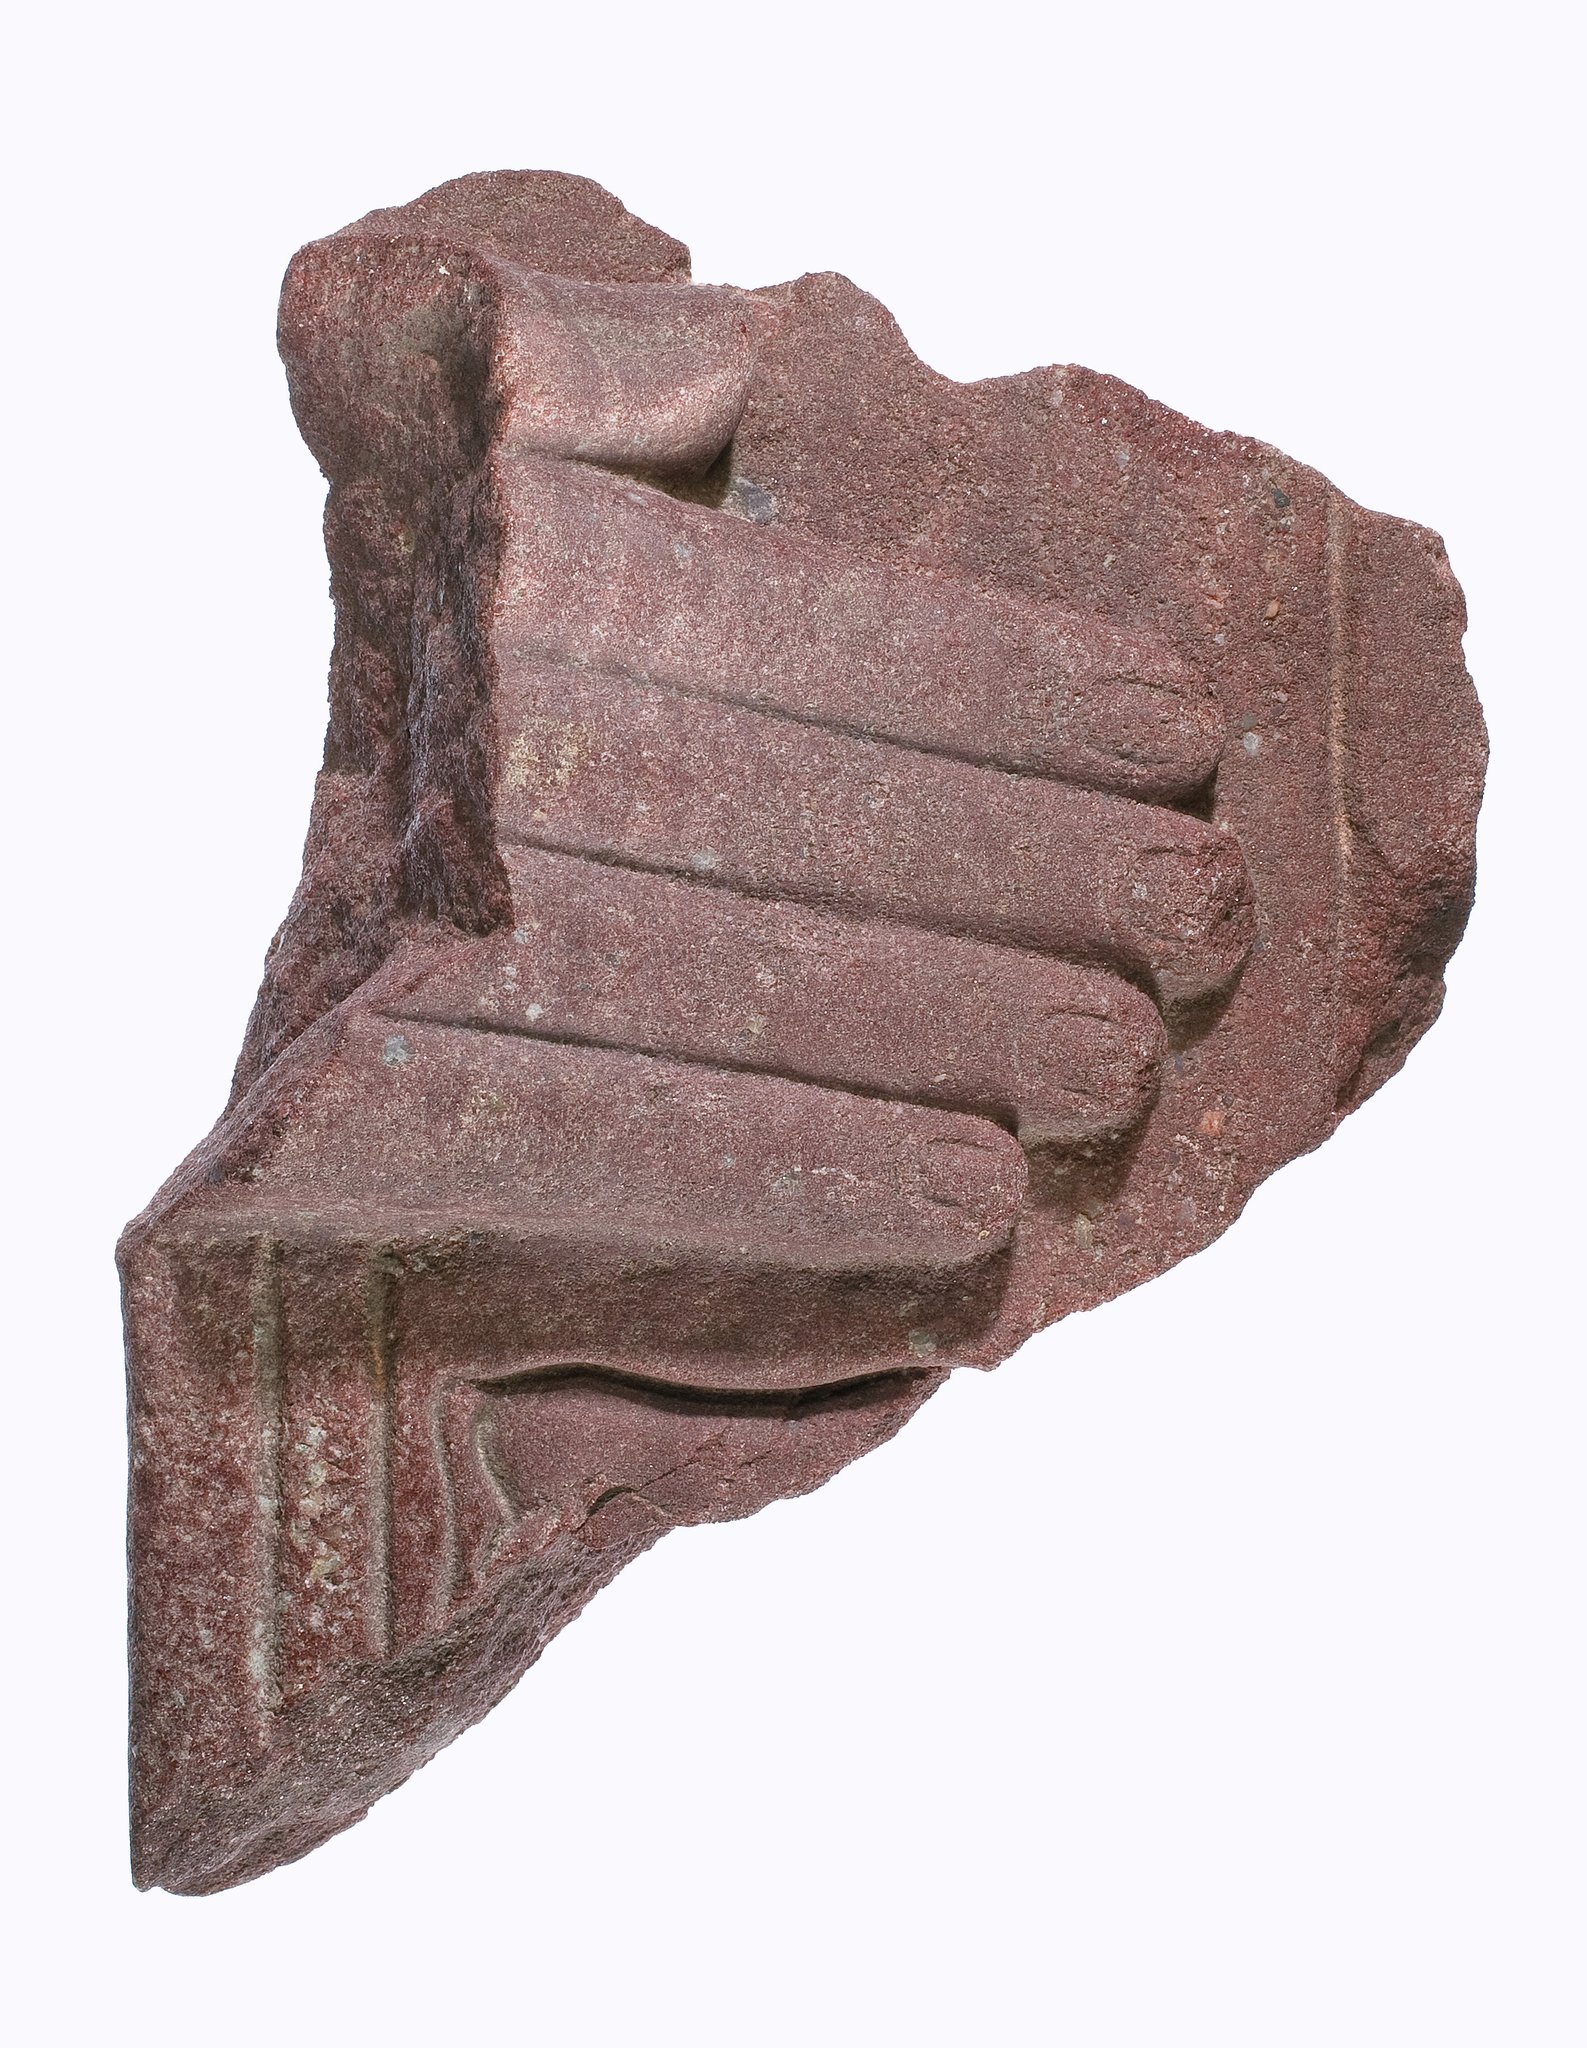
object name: hand, stela, horus name of akhenaten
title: Hand from a stelophorous statue with part of the Horus name of Akhenaten (?)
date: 1353-1336 BCE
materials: quartzite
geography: egypt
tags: hands